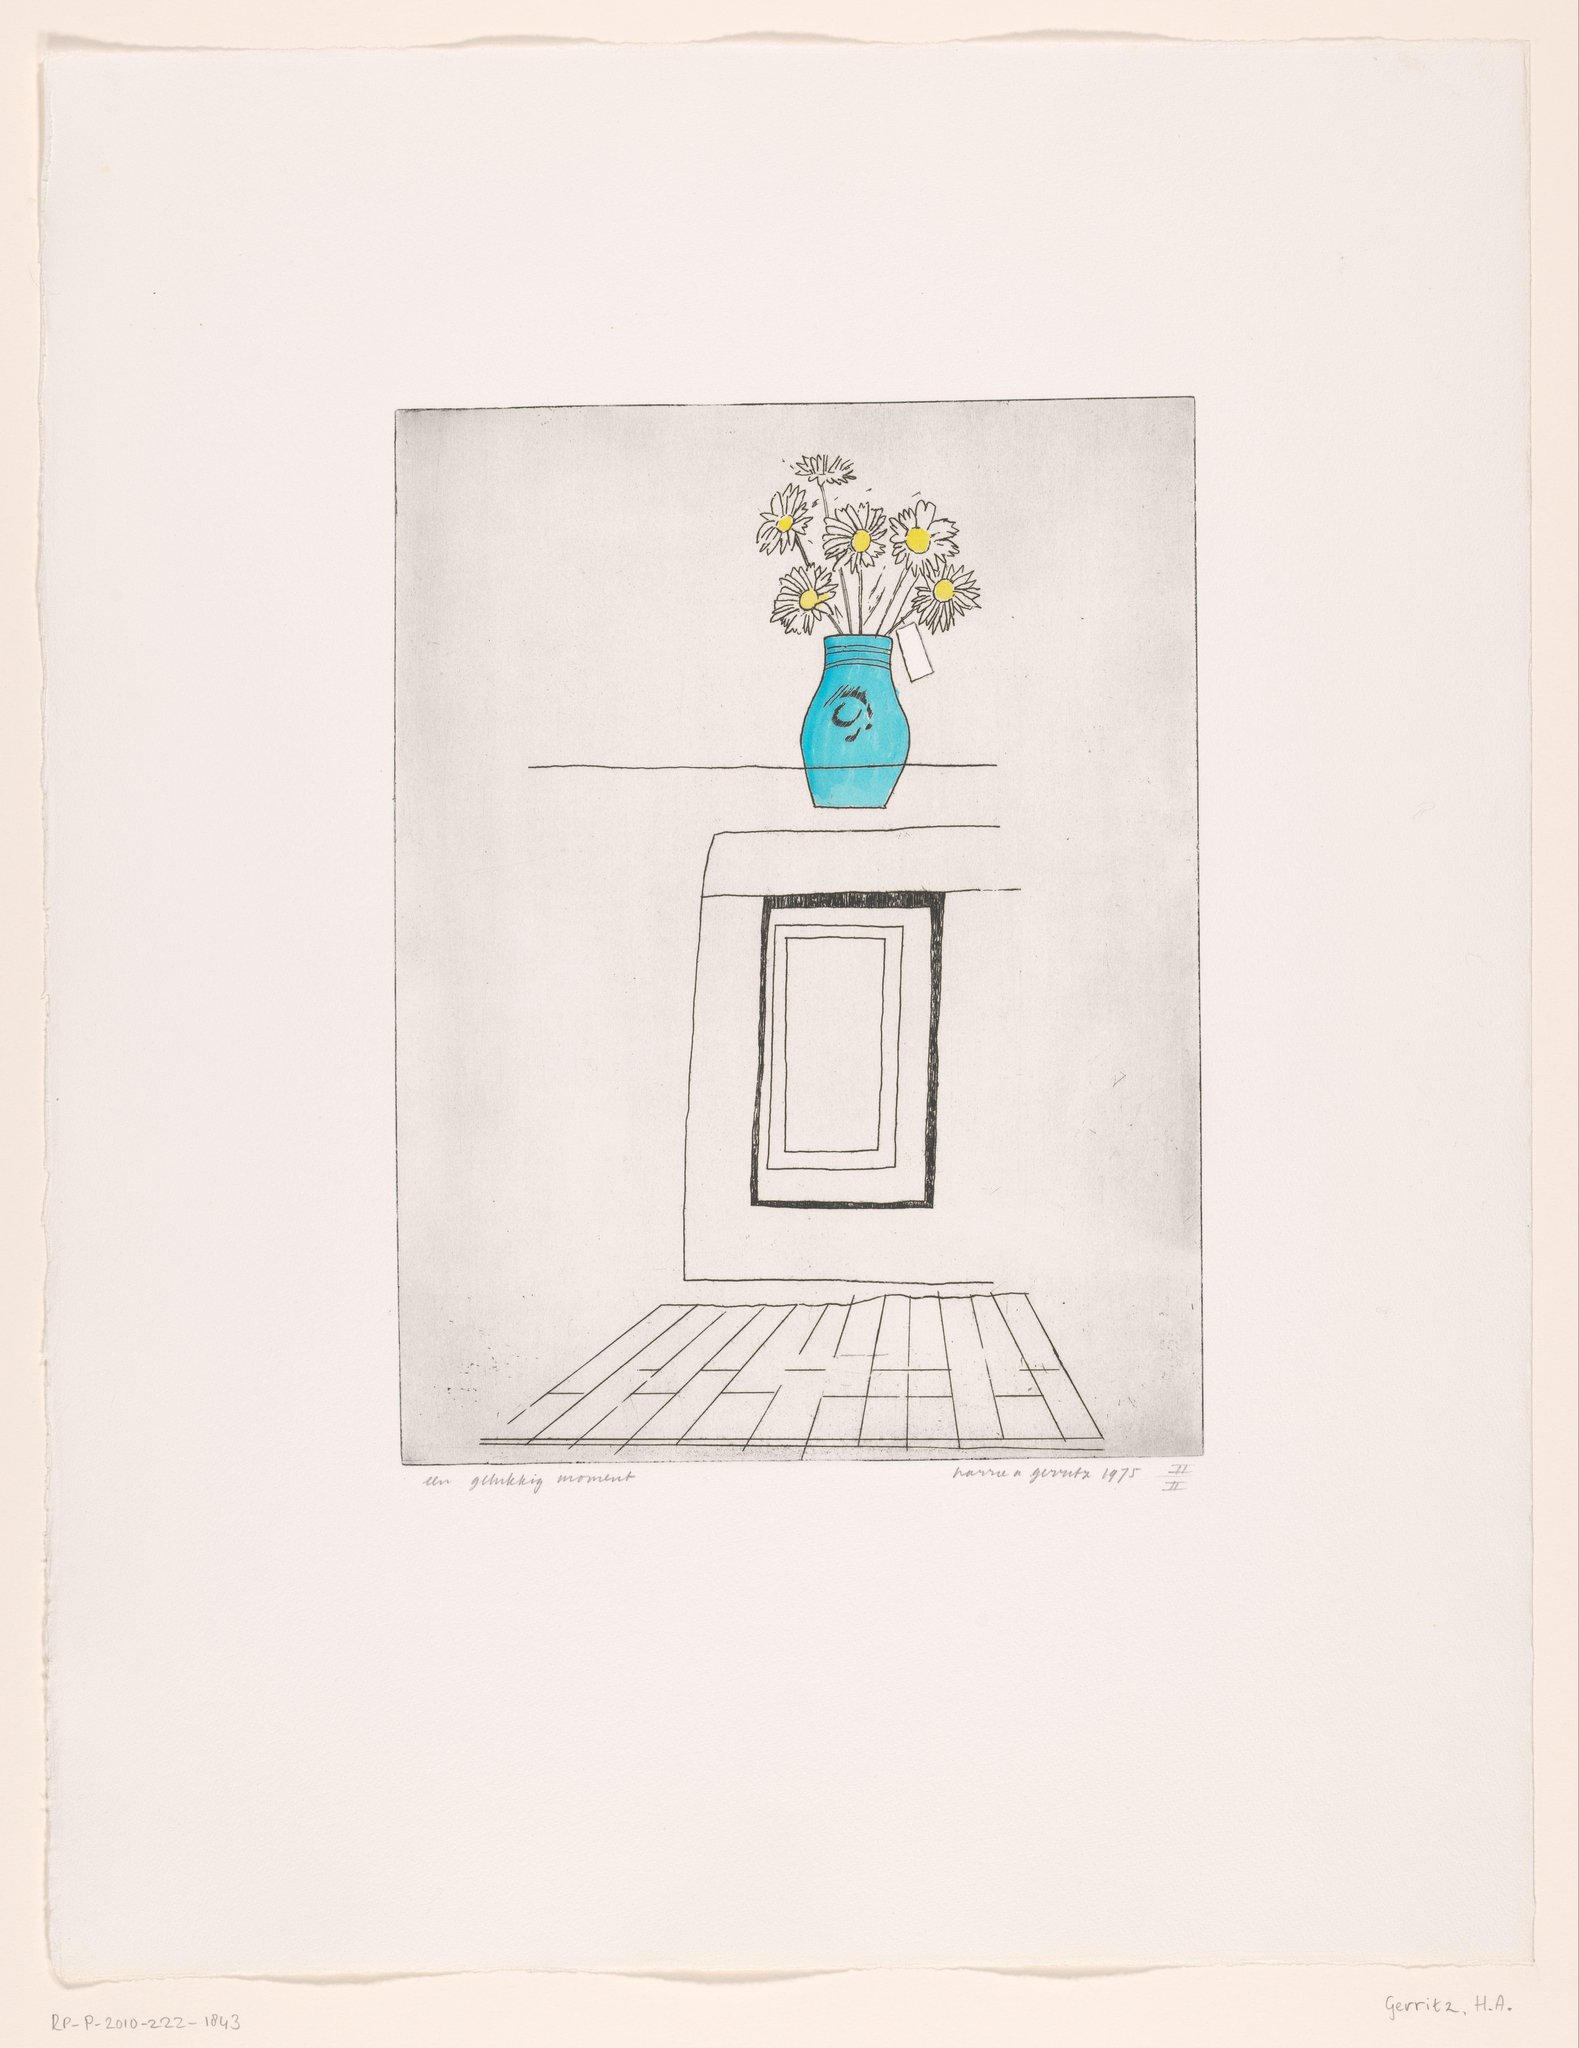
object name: print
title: Een gelukkig moment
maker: harrie a. gerritz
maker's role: draughtsman, painter, print maker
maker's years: 1940-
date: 1975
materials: paper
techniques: etching, hand coloring, intaglio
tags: cut flowers; nosegay, bunch of flowers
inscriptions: collector's mark: Lugt 2228, inscription: ‘PC’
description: Steeds kleiner wordende rechthoeken met daarboven een blauwe vaas met bloemen waar een blanco kaartje aan hangt.